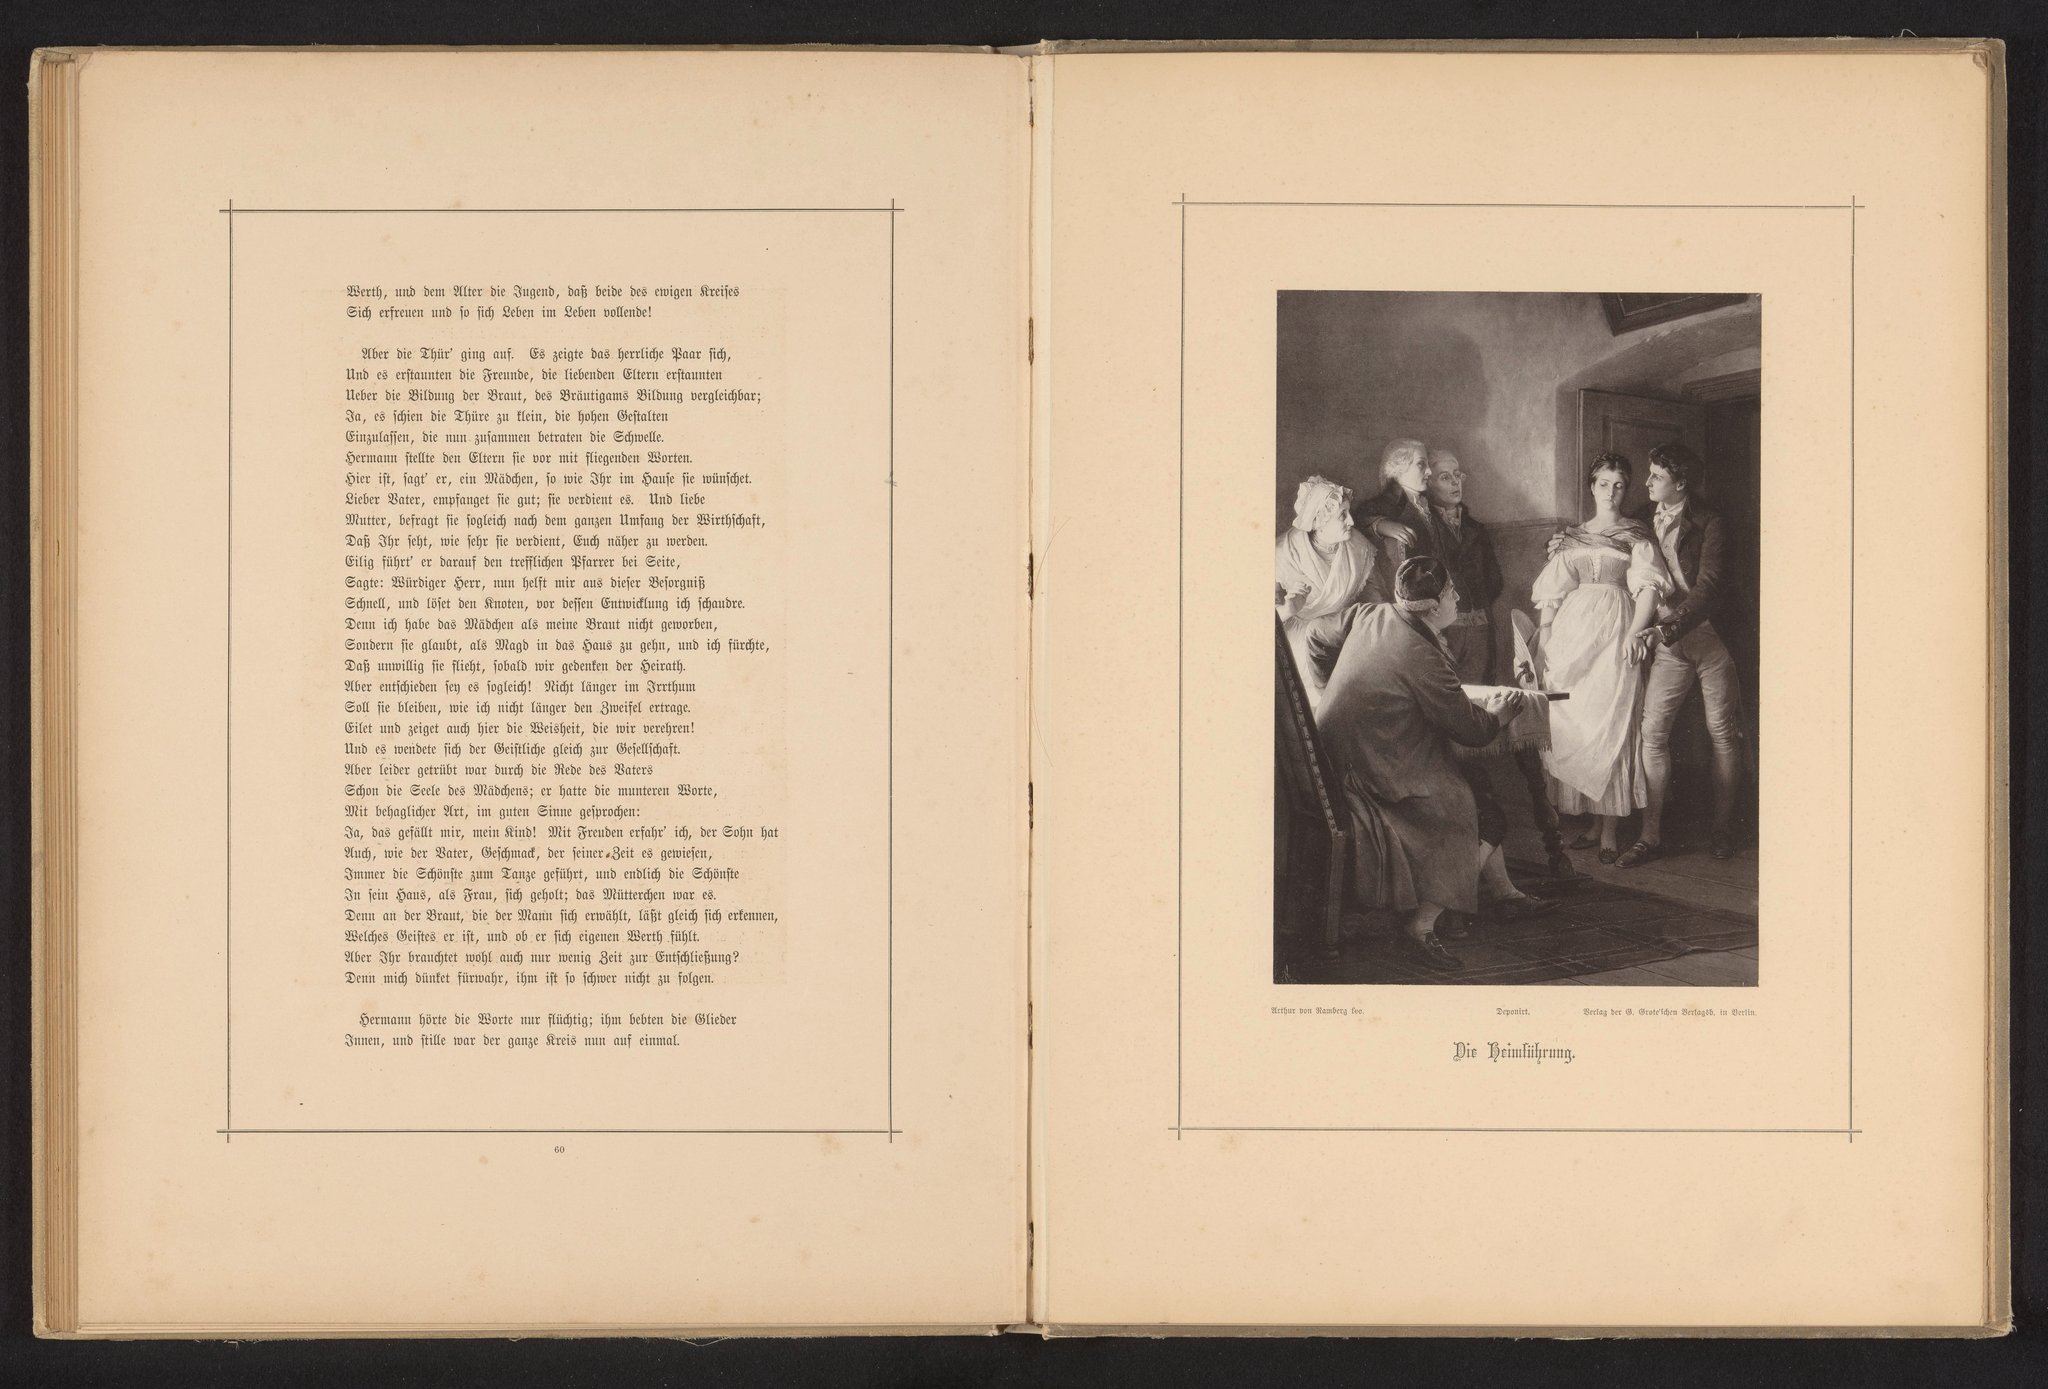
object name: photomechanical print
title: Heimkehr beim Anzug des Gewitters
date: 1876-1881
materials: paper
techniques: photograph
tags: adolescent, young woman, maiden, youth, adolescent, interior ~ representation of a building, parents (first degree family relationships)